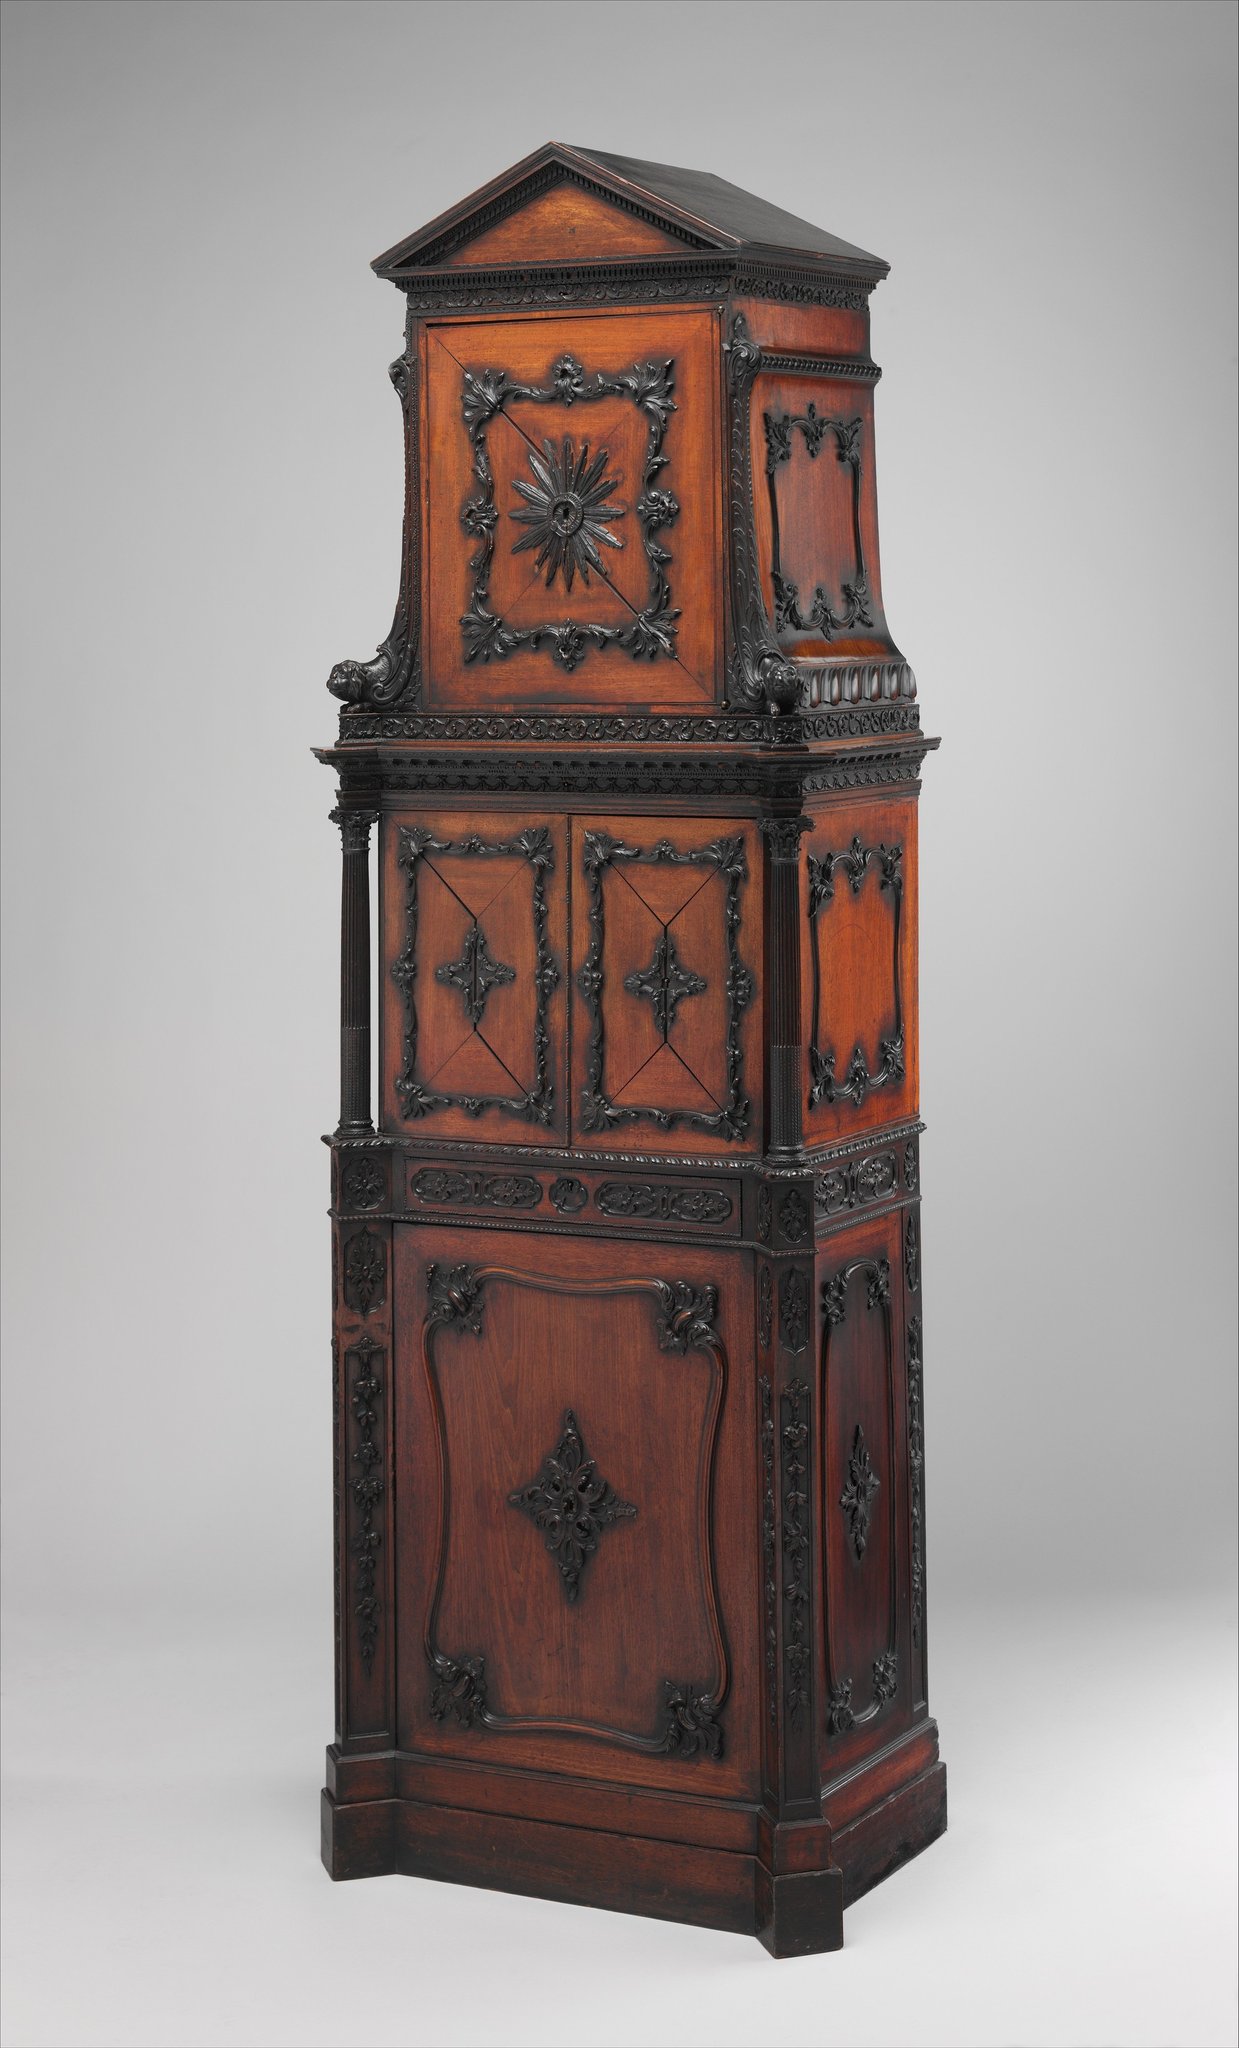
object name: medal cabinet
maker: william vile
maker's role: maker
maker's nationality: british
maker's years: 1715-1767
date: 1760-1761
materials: wood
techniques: carving